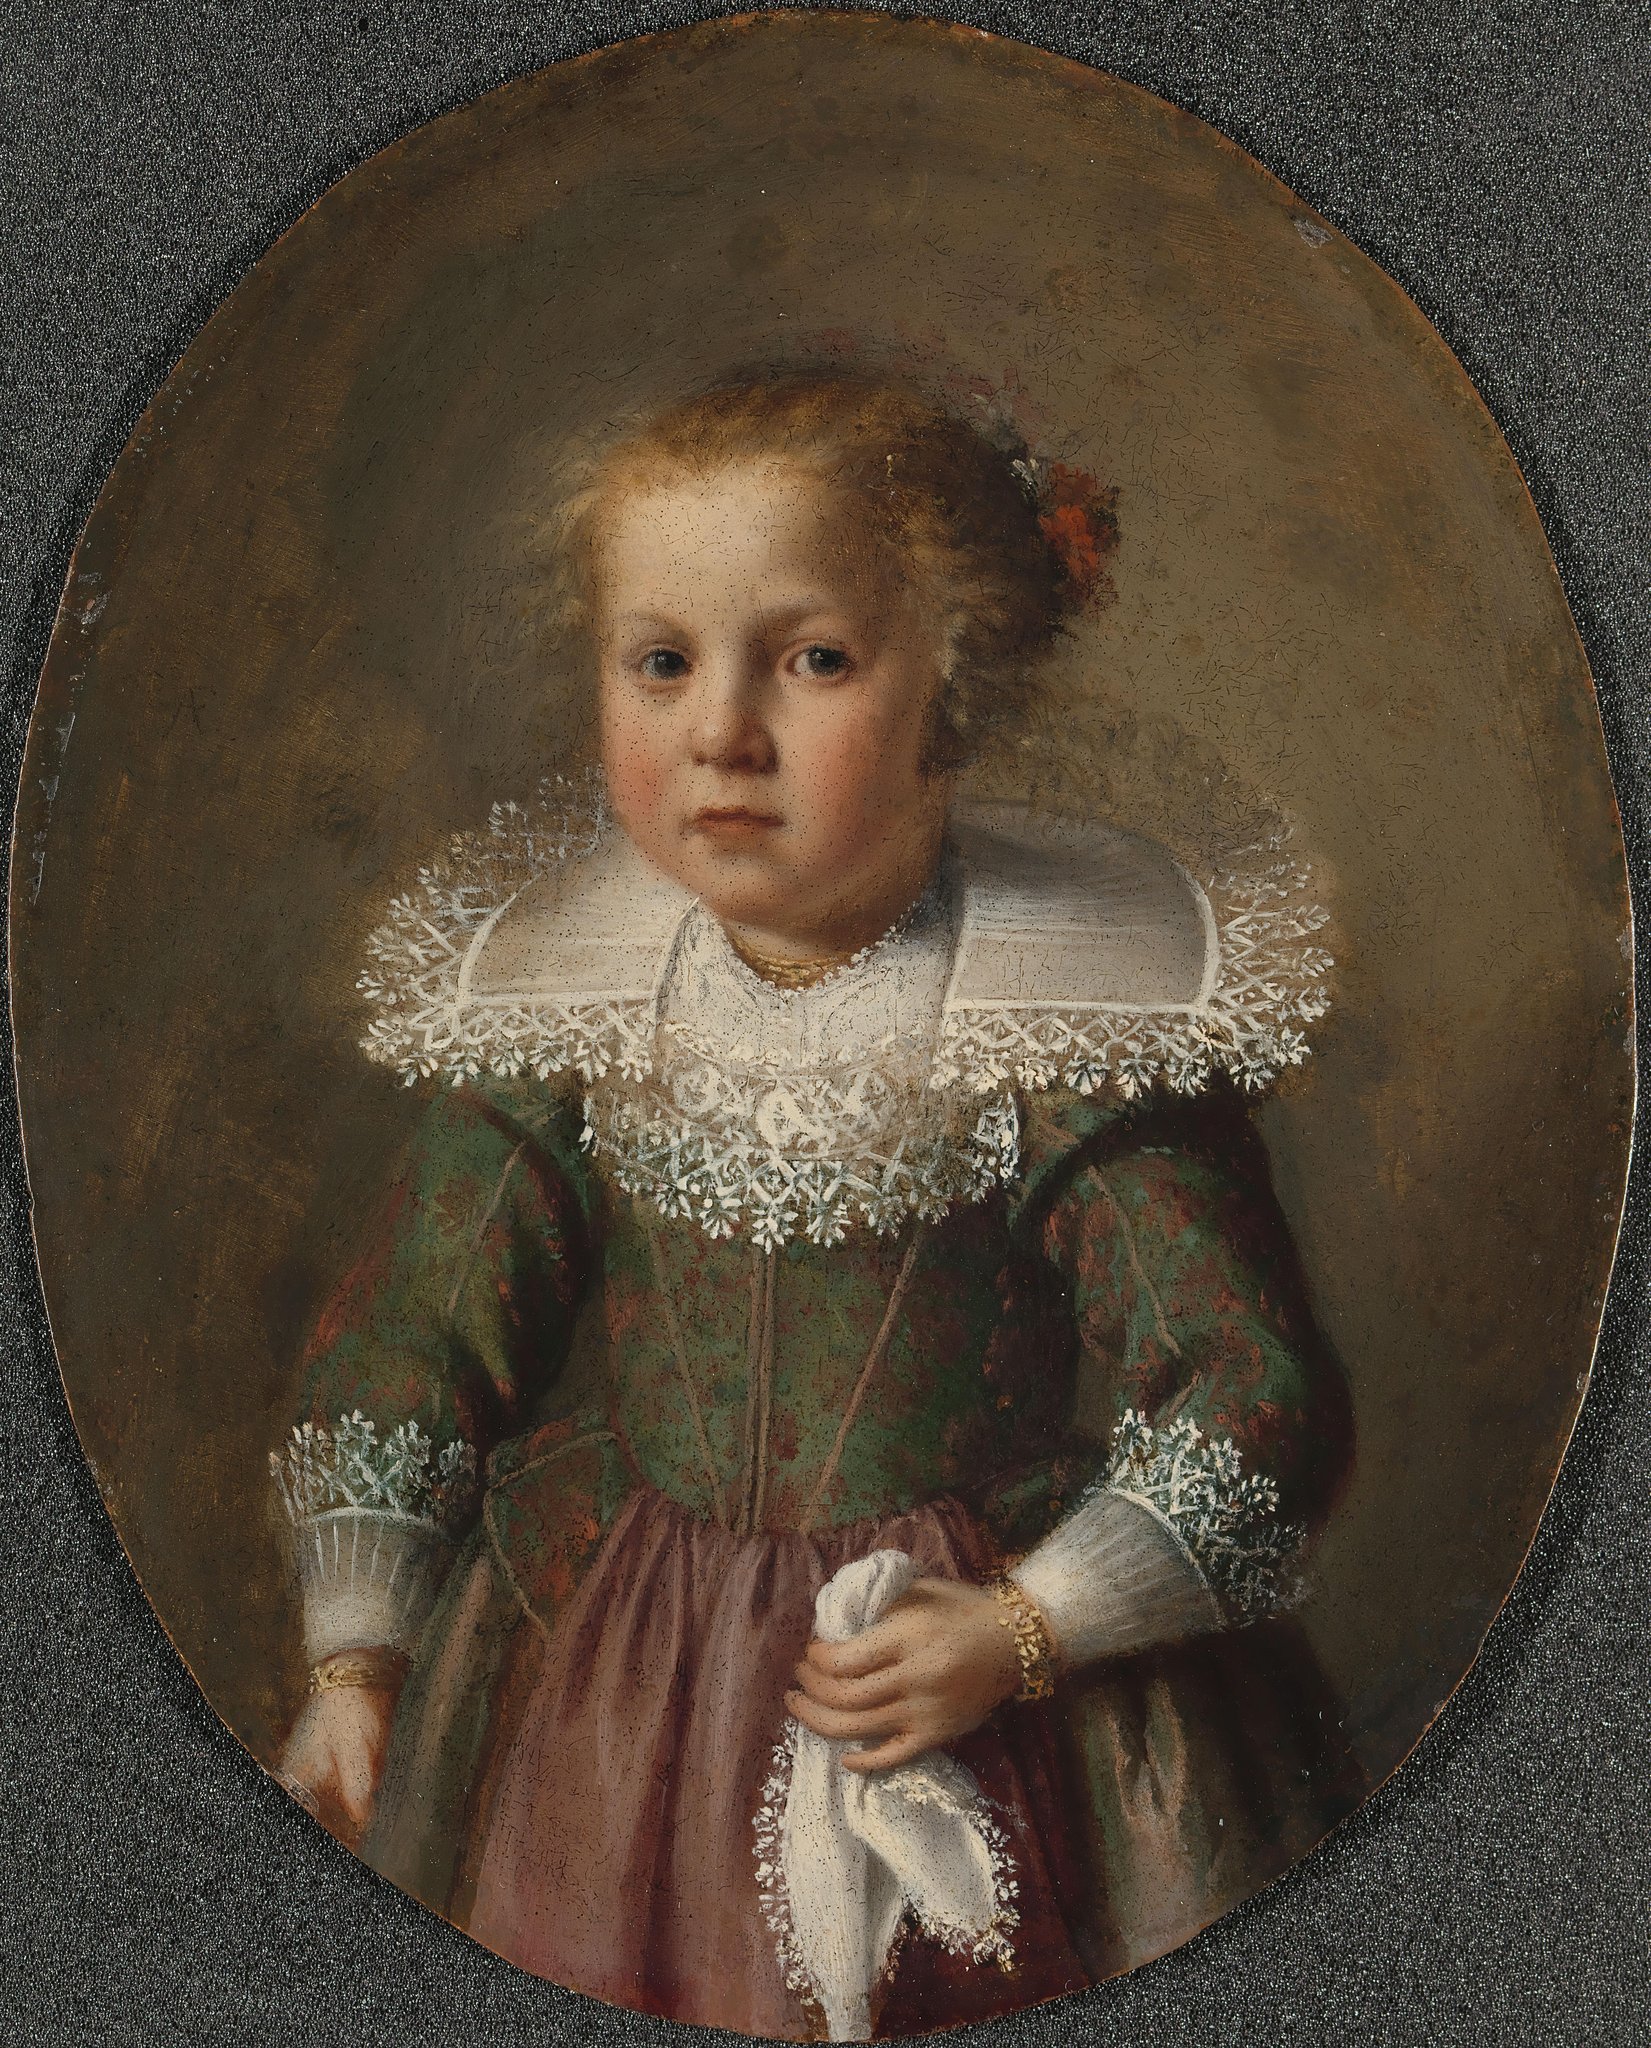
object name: painting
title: Portrait of Josina Cornelisdr van Esch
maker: Anonymous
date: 1632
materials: copper, oil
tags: historical persons - bb - woman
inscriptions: inscription, centre left: ‘Æ[...]’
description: Portret van Josina, dochter van Cornelis Samuelsz. van Esch en Josina Jansdr. de Carpentier. Ten halven lijve, iets naar links, een zakdoek in de linkerhand. Onderdeel van een serie van zeven ovale portretten van Cornelis Samuelsz van Esch, zijn vrouw Josina Jansdr de Carpentier, hun drie dochtertjes en twee zoontjes (SK-A-1747-A/G).